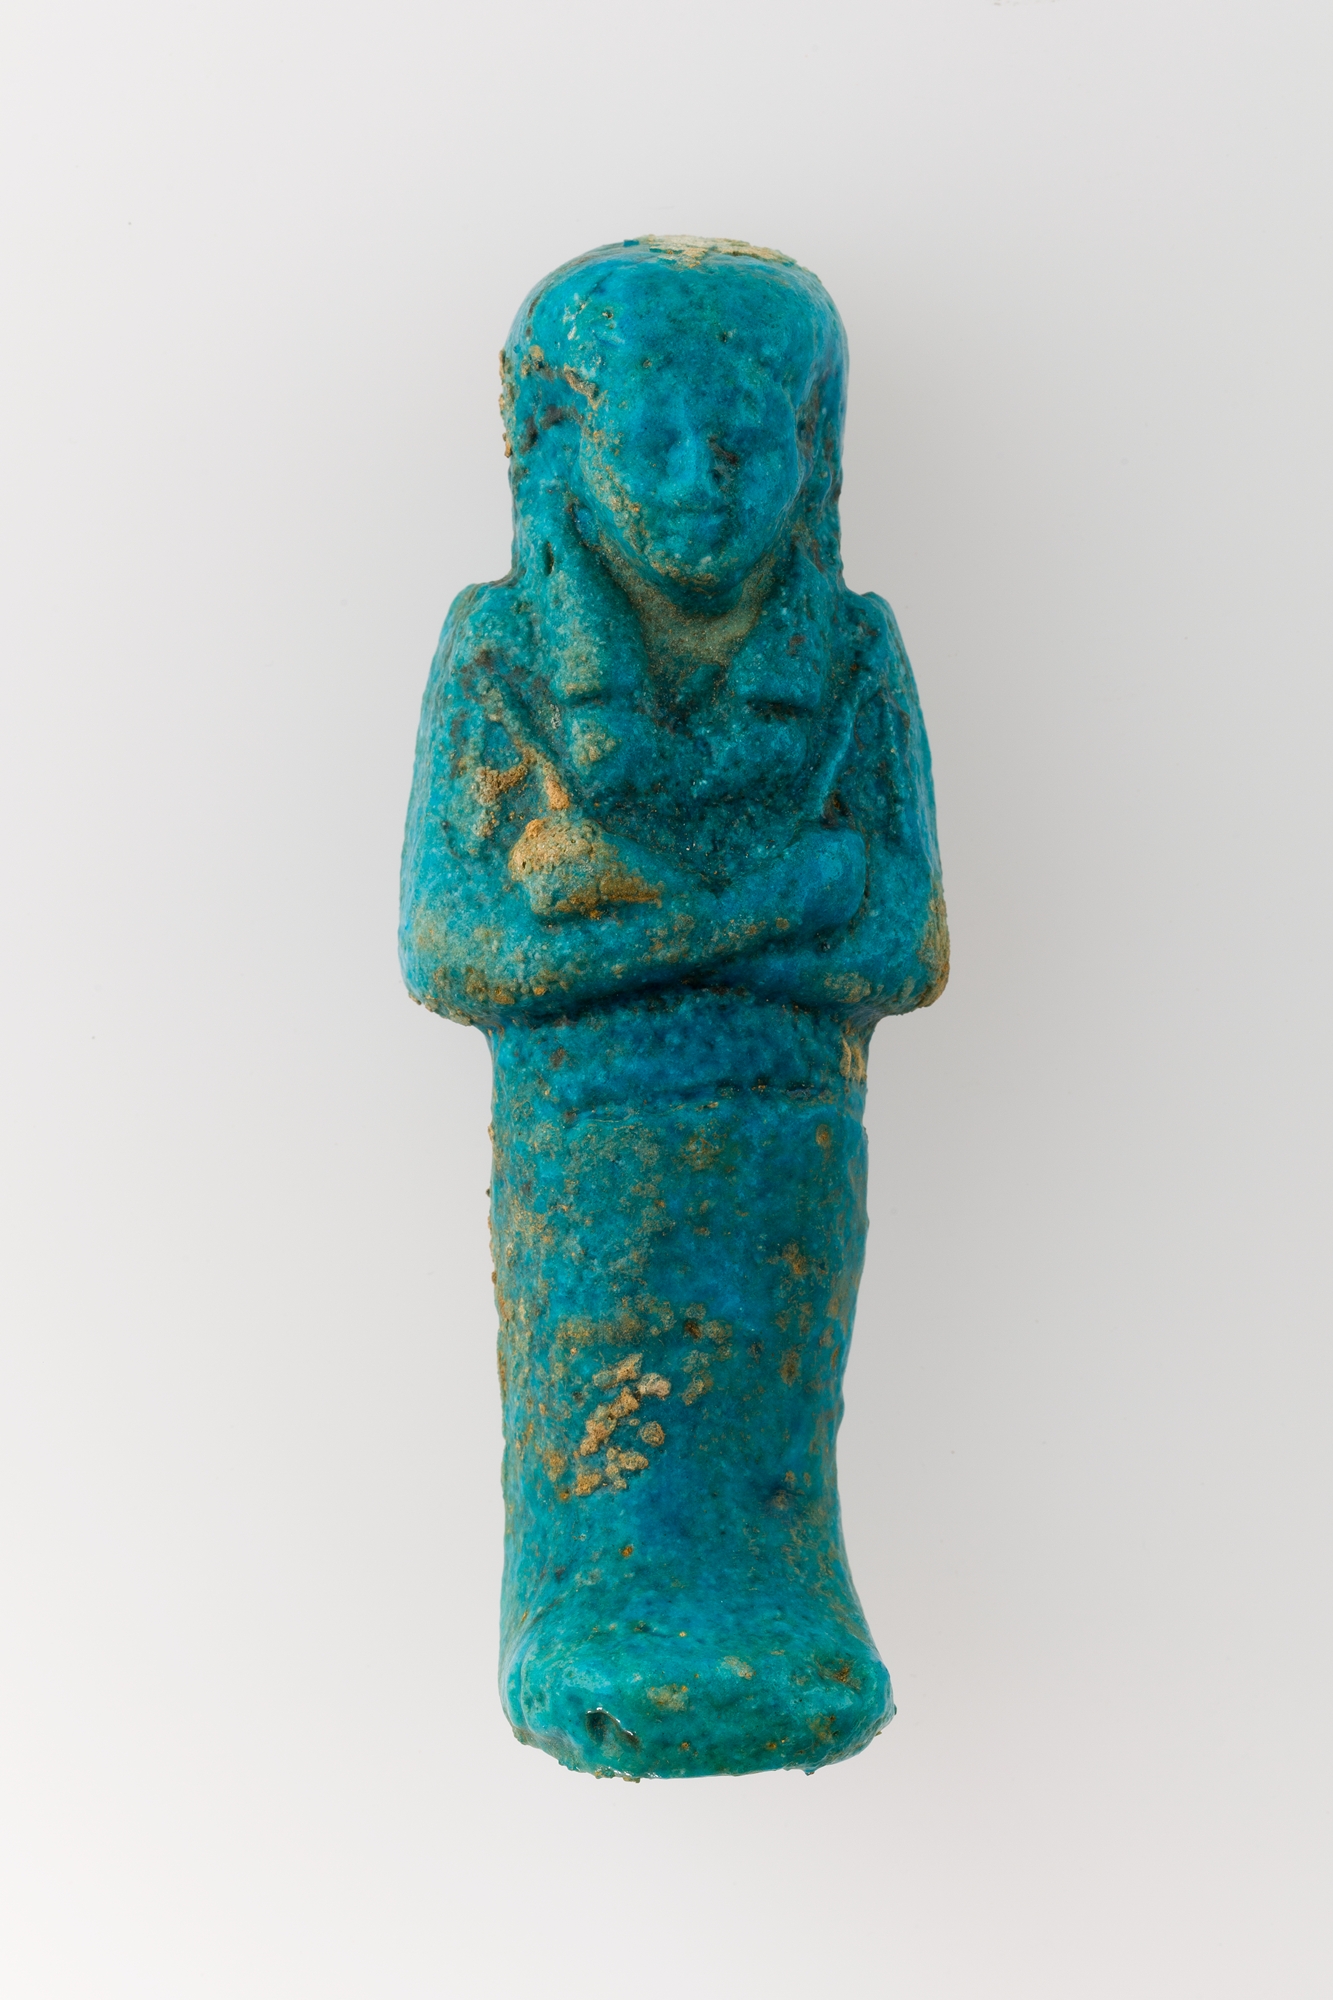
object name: shabti, henettawy c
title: Worker Shabti of Henettawy (C), Daughter of Isetemkheb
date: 990-970 BCE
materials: faience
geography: egypt